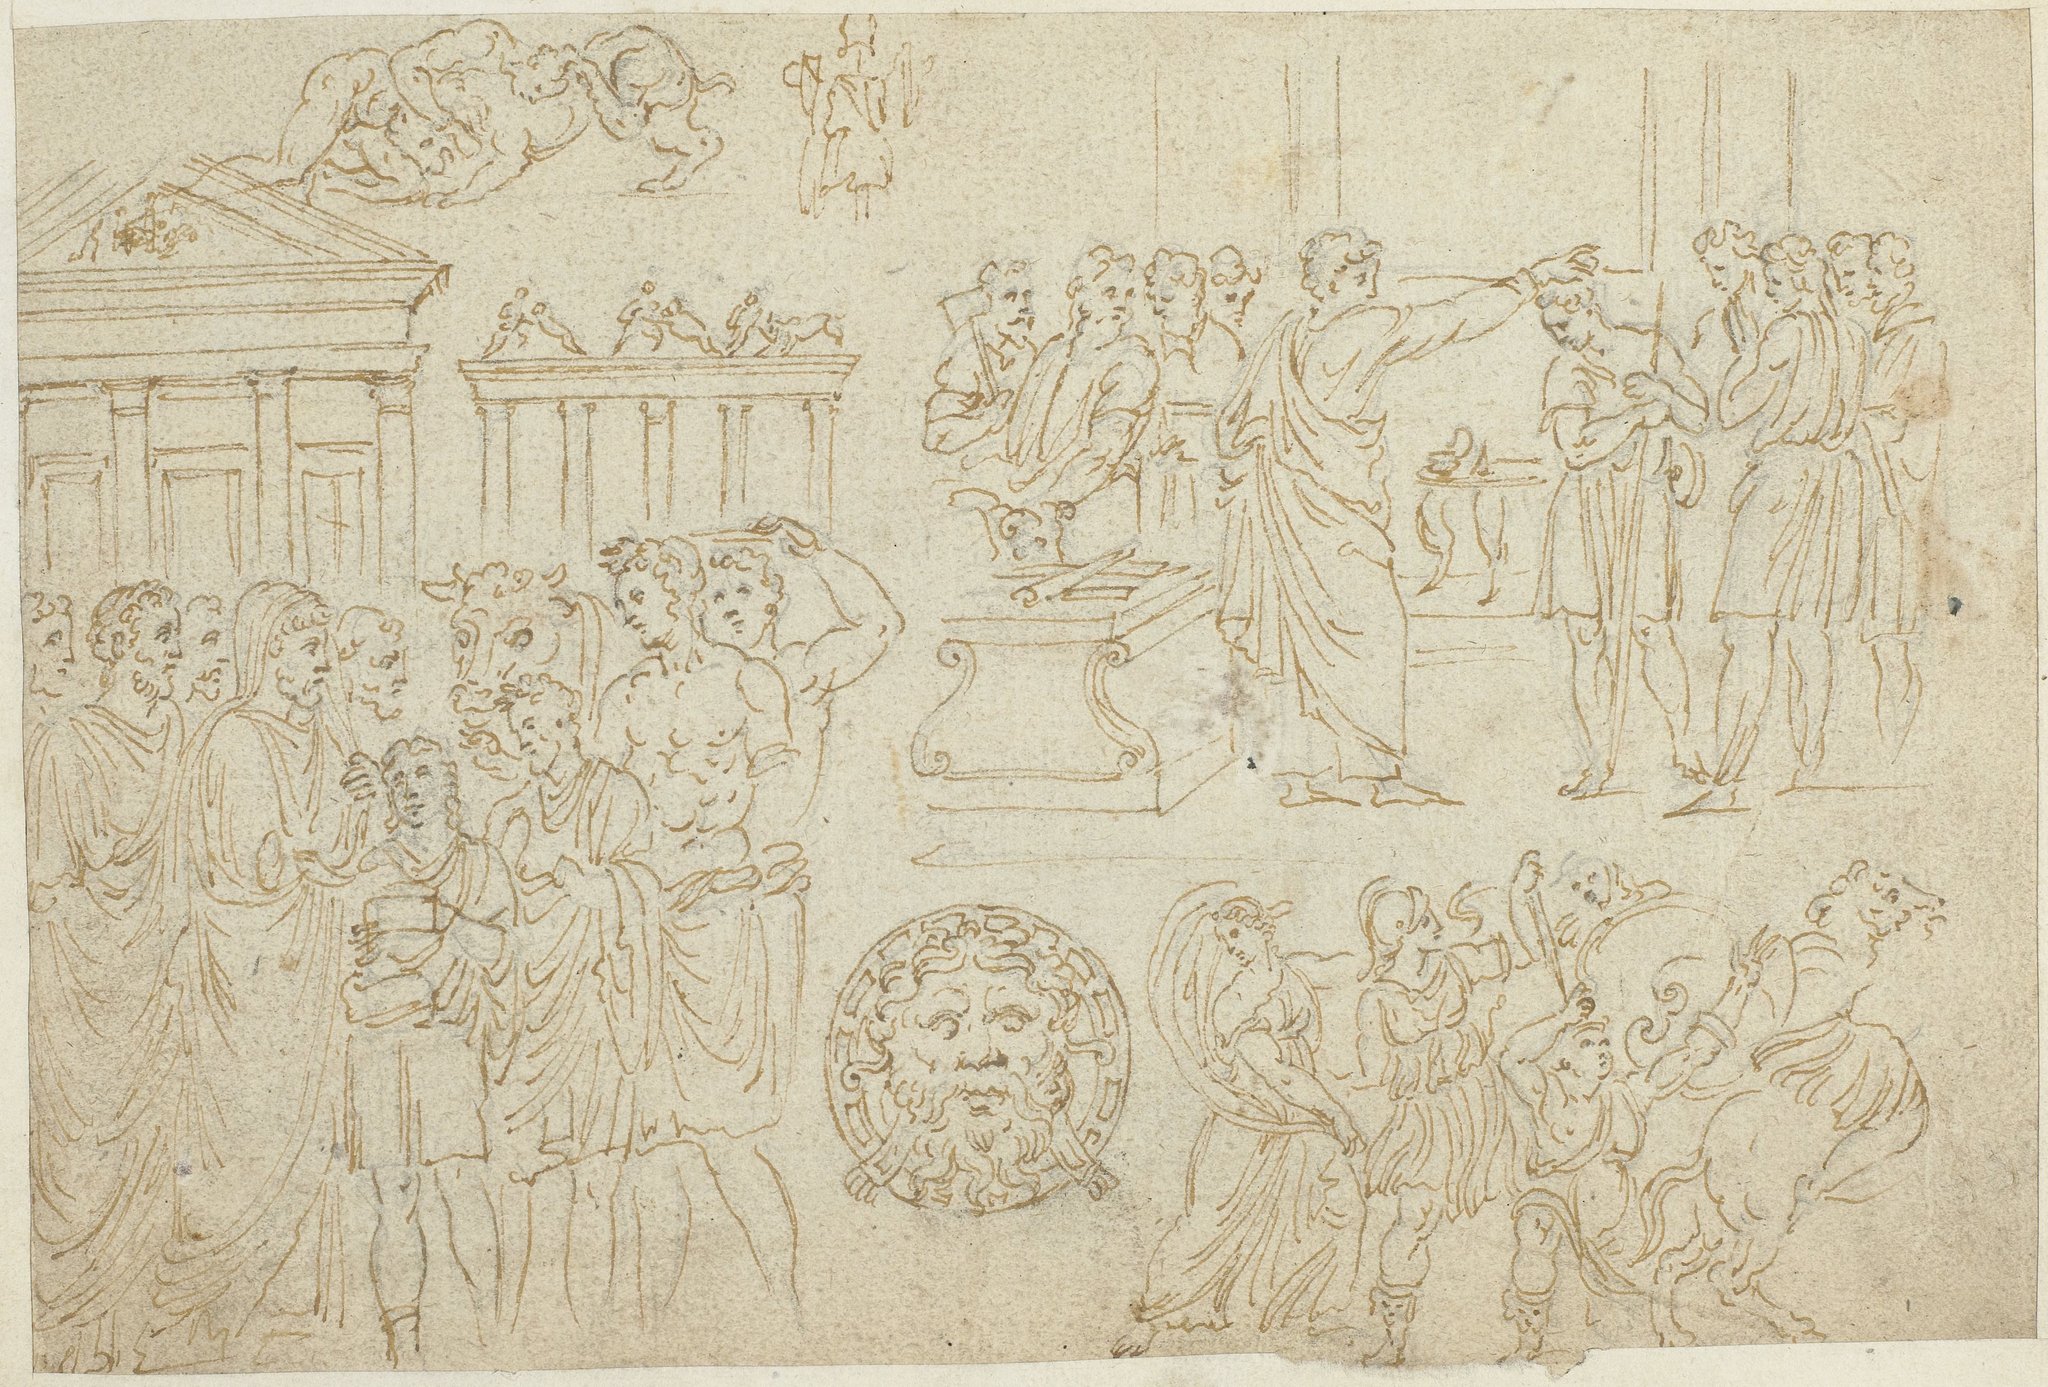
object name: kopie naar fresco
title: Beelden en fresco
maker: Anonymous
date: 1550-1570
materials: chalk, ink, paper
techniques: pen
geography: low countries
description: Album "Maarten de Vos schetsboek", blad 5r(12).